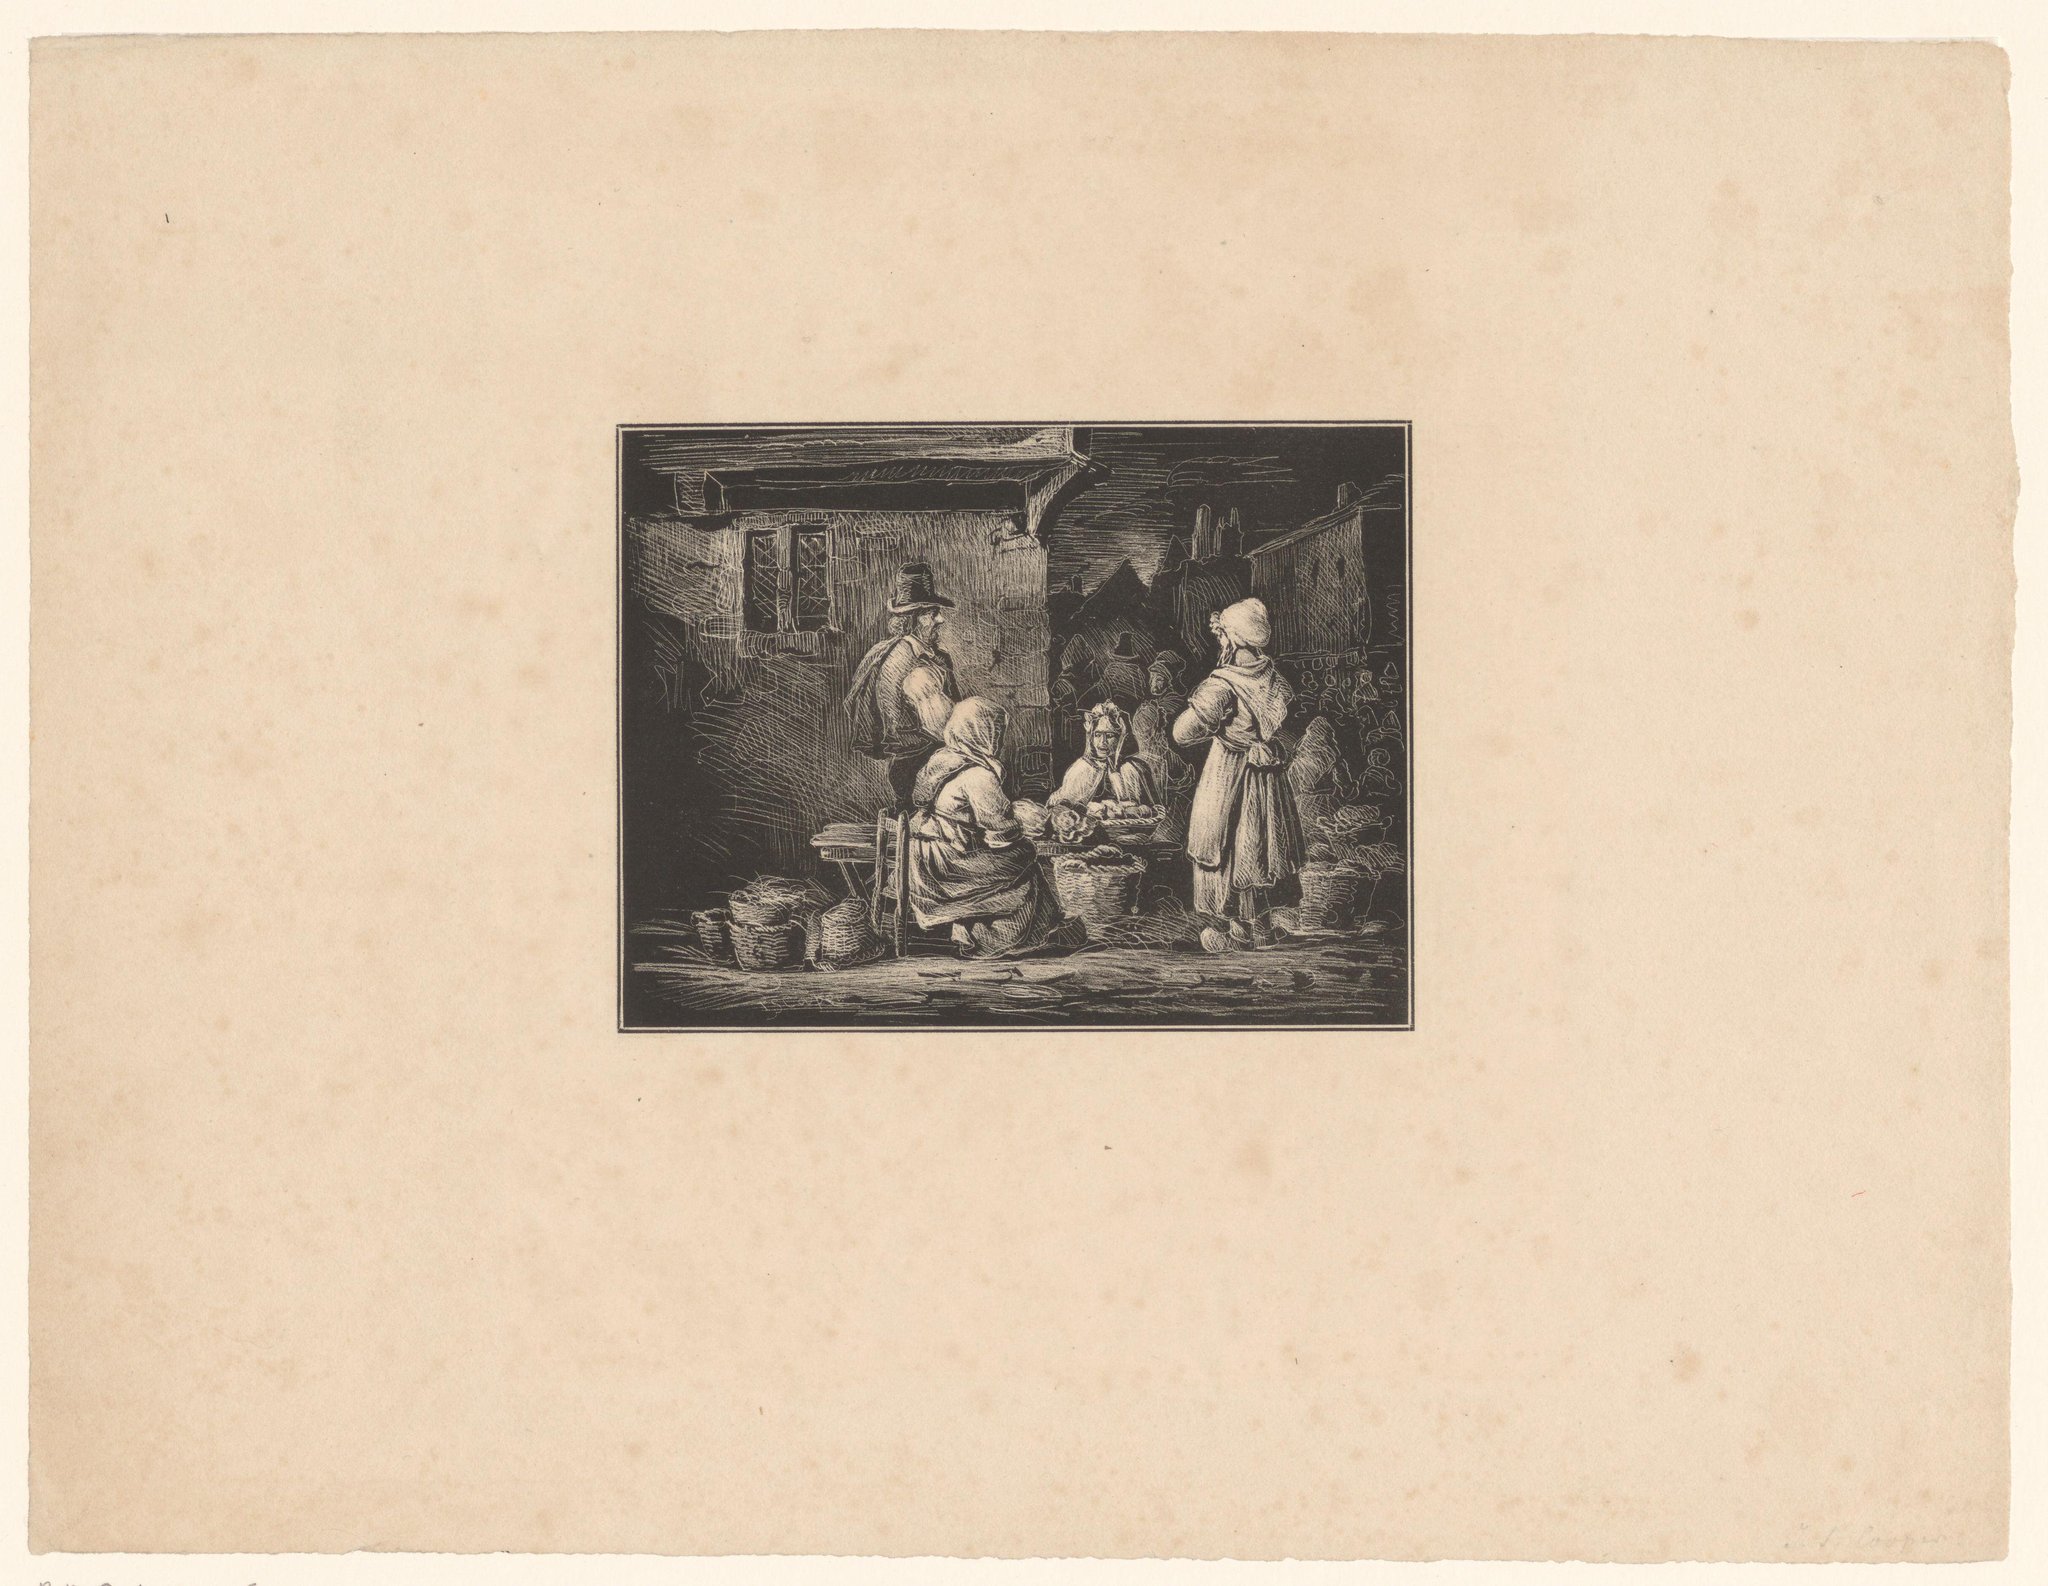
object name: print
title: Gezicht op een markt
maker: thomas sidney cooper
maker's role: print maker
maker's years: 1803-1902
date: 1813-1902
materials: paper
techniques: lithograph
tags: market, street (+ city(-scape) with figures, staffage)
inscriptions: collector's mark: Lugt 2228